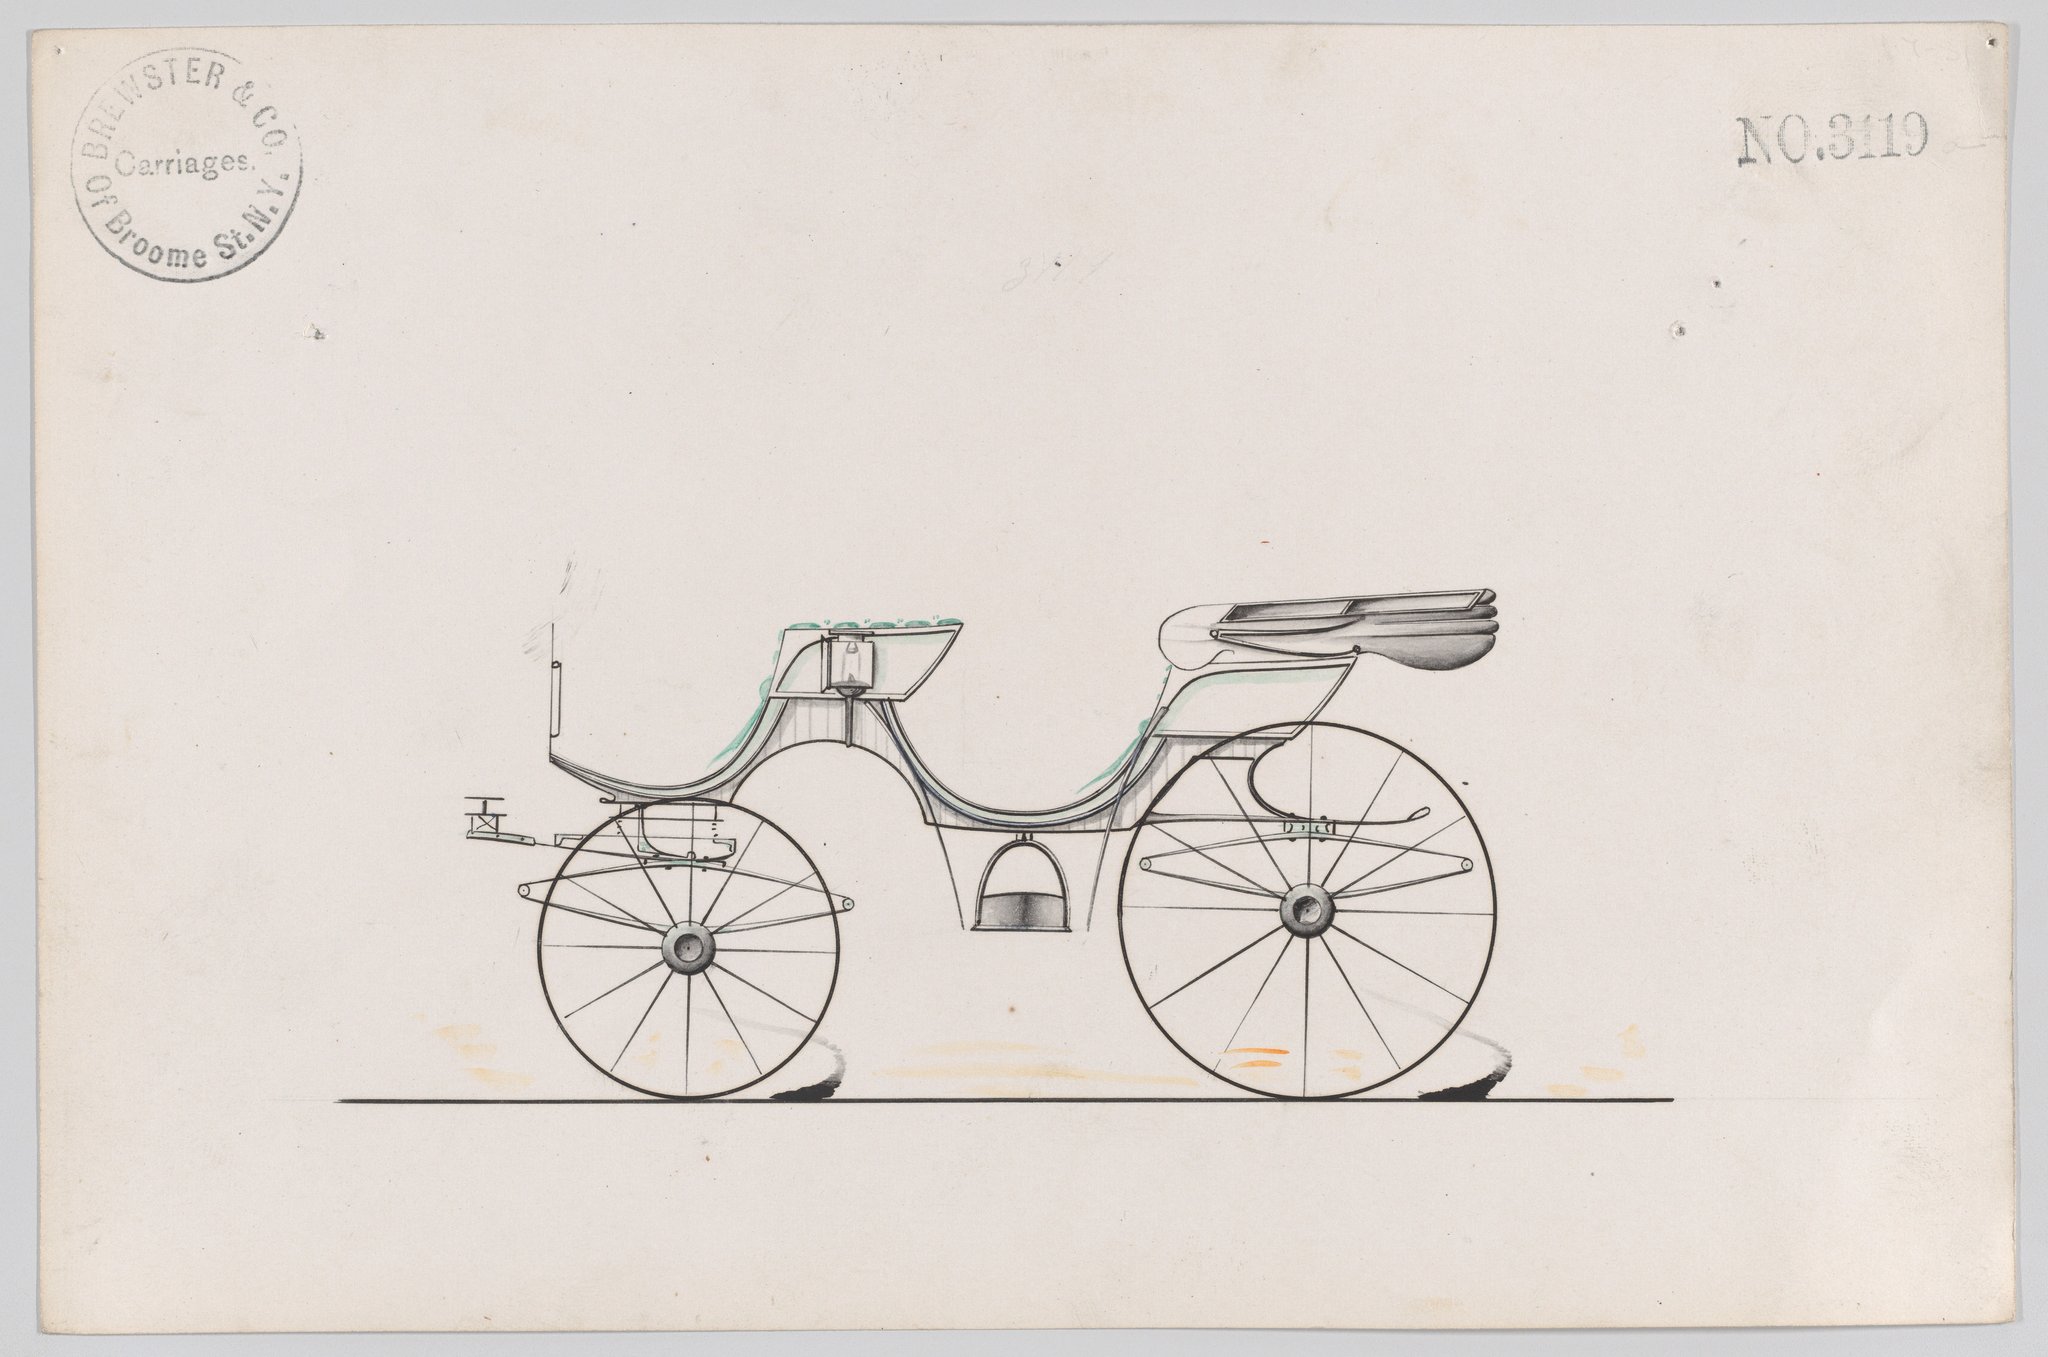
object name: drawing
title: Design for Cabriolet Phaeton, no. 3119a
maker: brewster & co.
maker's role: manufacturer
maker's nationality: american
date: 1875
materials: gouache, ink, watercolor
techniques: pen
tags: carriages